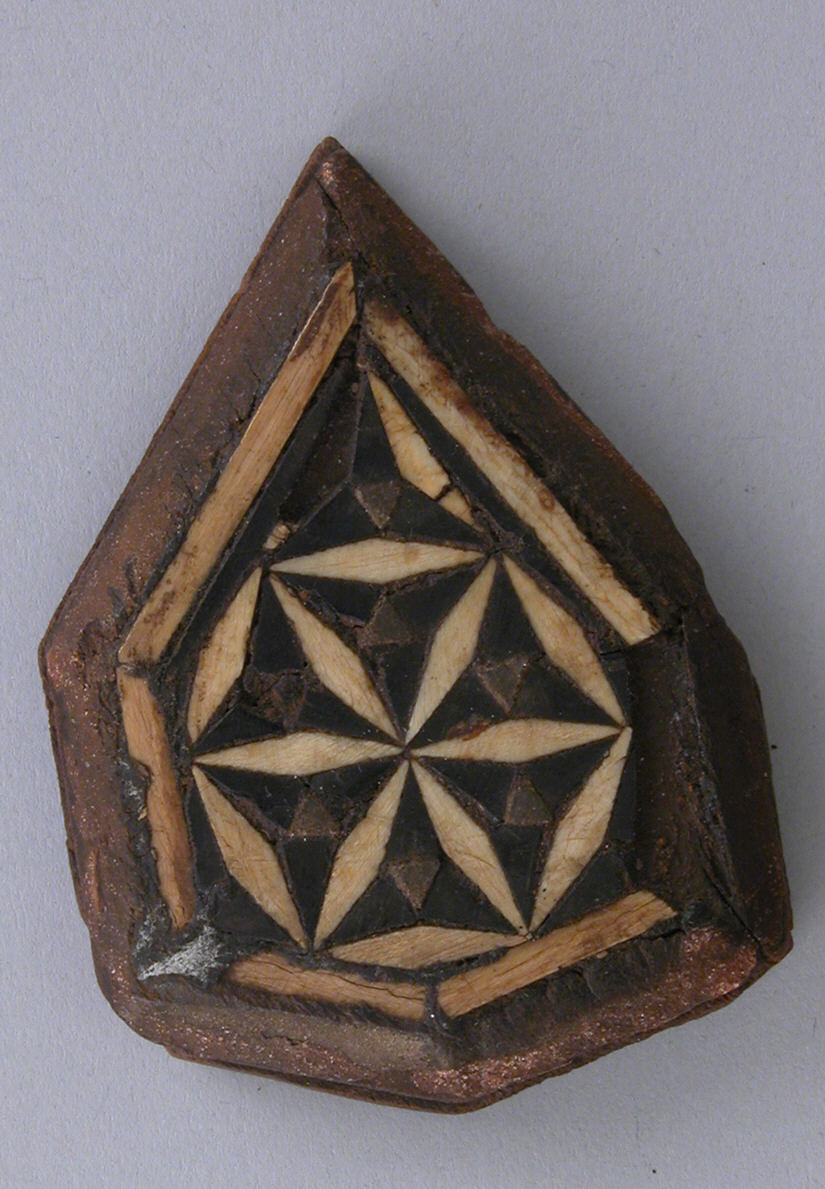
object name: panel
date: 1301-1500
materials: ivory, wood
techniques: inlay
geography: egypt